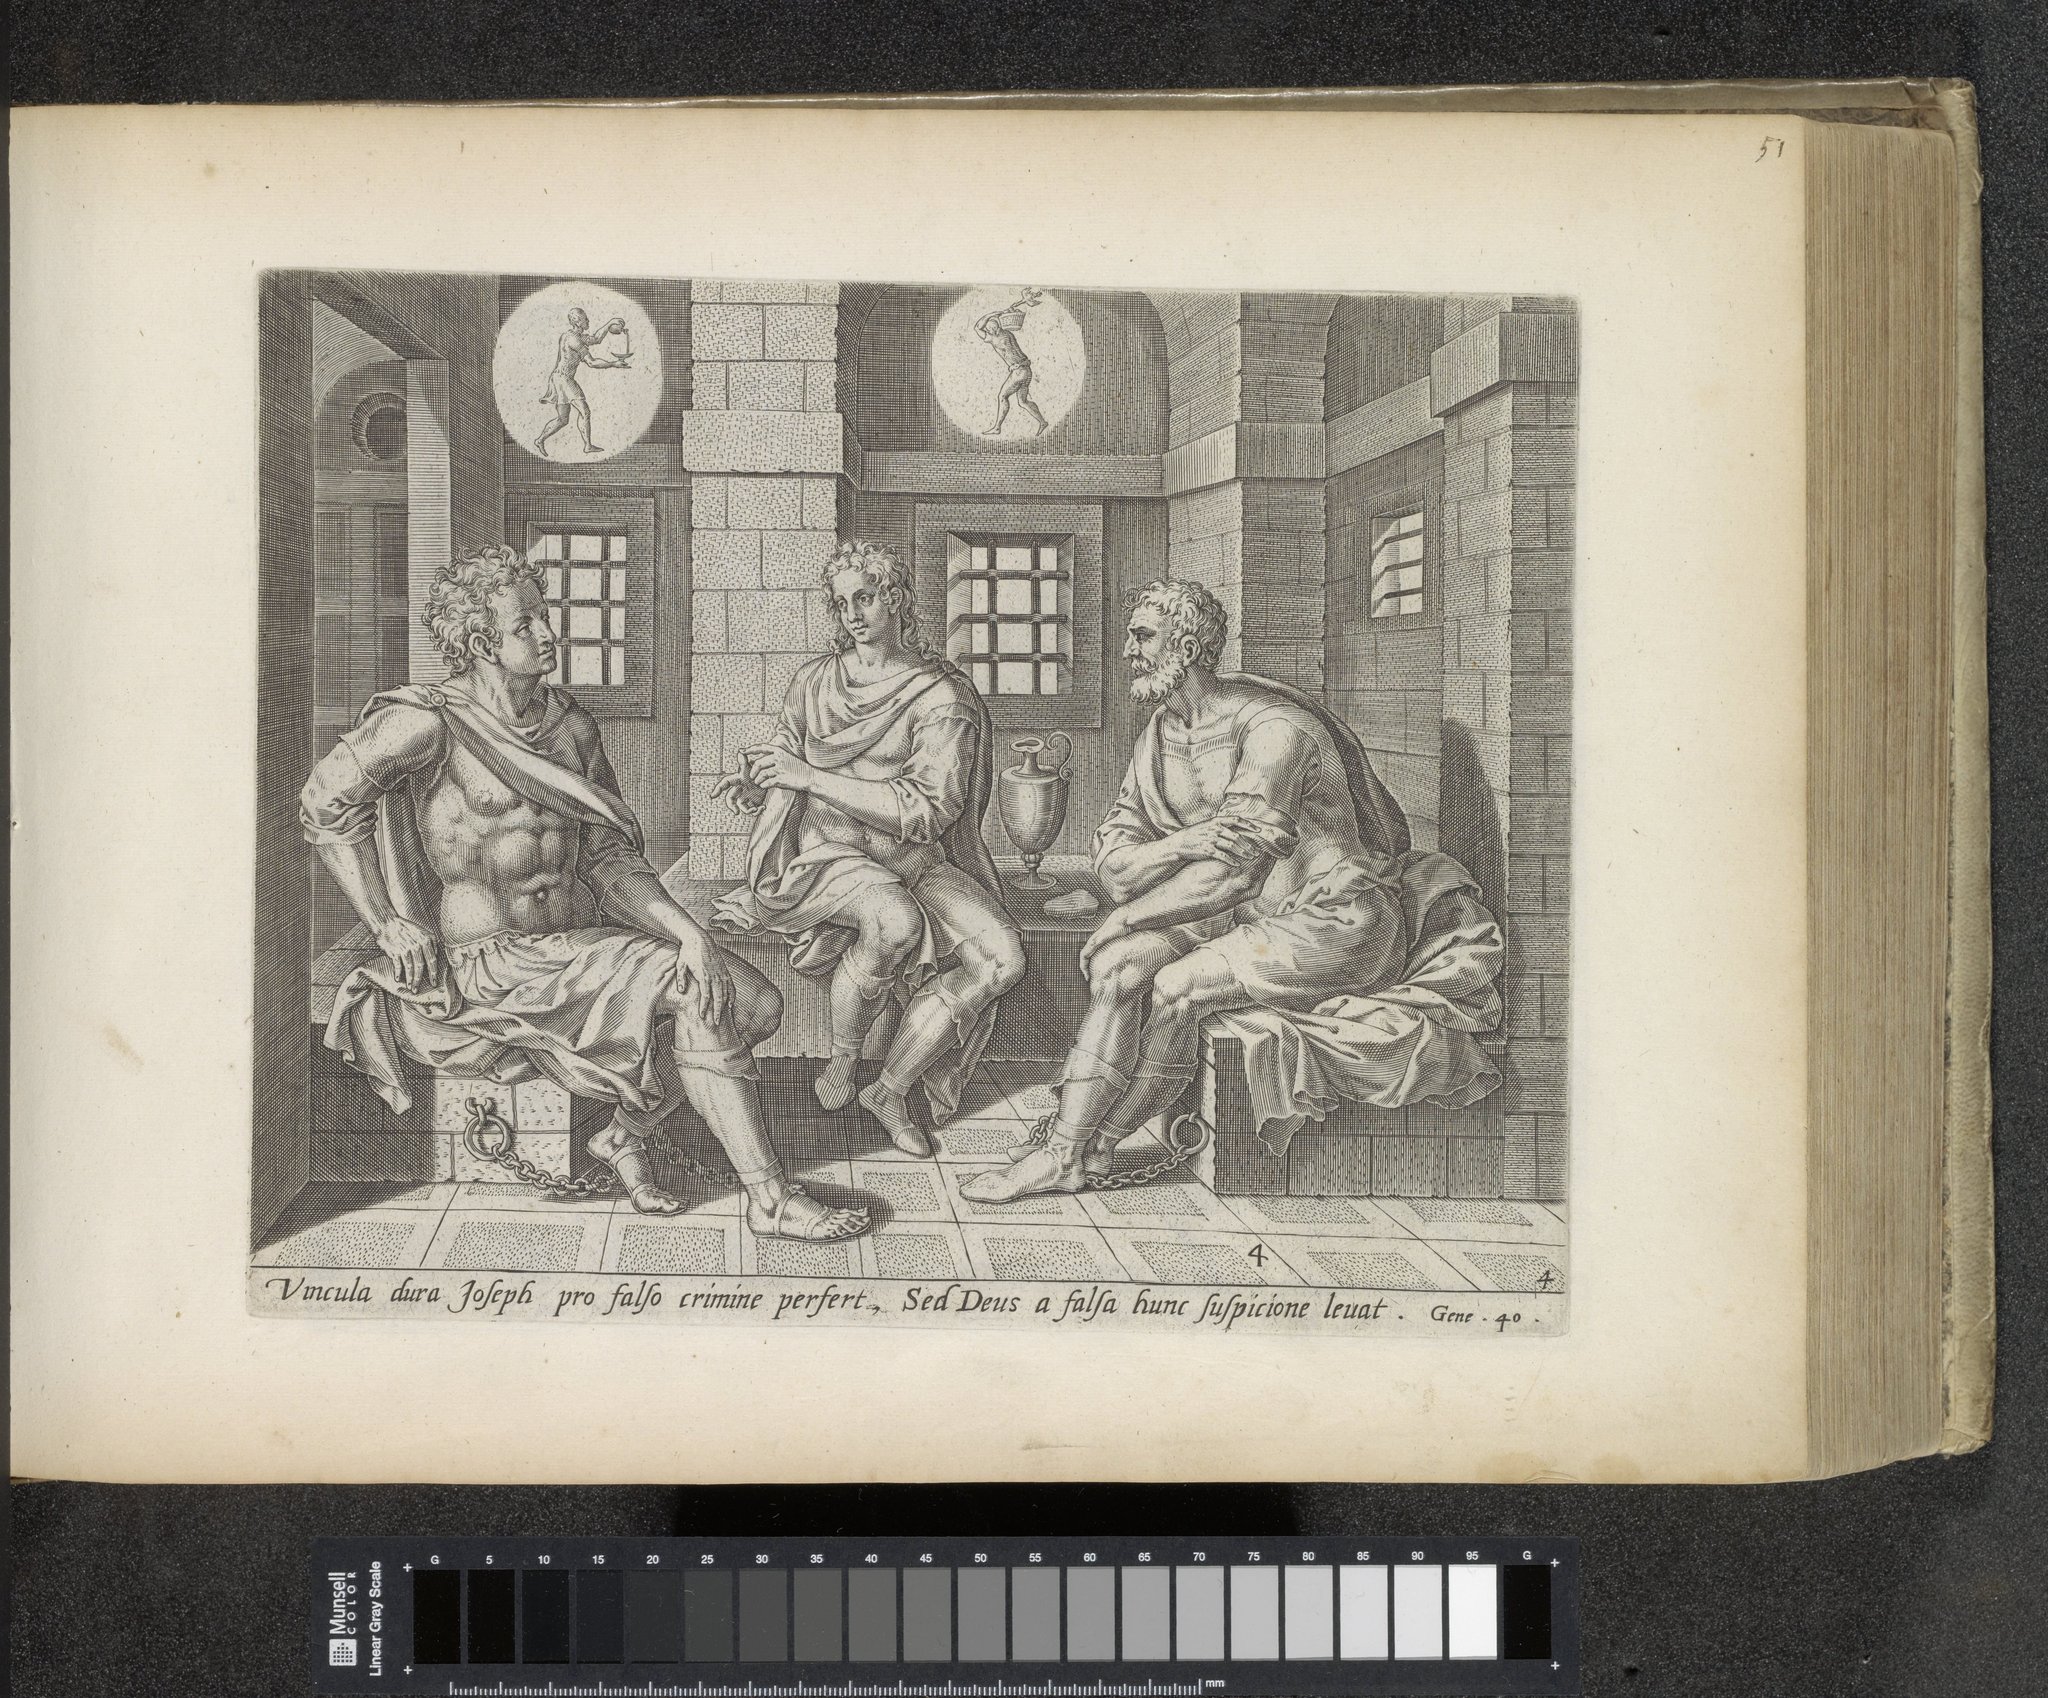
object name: album leaf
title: Jozef legt de dromen uit van de schenker en de bakker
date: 1579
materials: paper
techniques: engraving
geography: amsterdam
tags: joseph interpreting the dreams of the butler and the baker (the two dreams combined)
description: Jozef legt in de gevangenis de dromen uit van de schenker en de bakker van farao. Boven het hoofd van de schenker is de droom van de schenker verbeeld: hij giet wijn in een beker voor farao. Boven het hoofd van de bakker zijn droom: vogels pikken aan het brood dat hij in een mand draagt. Onder de voorstelling een verwijzing in het Latijn naar de Bijbeltekst in Gen. 40. Deze prent maakt deel uit van een album.